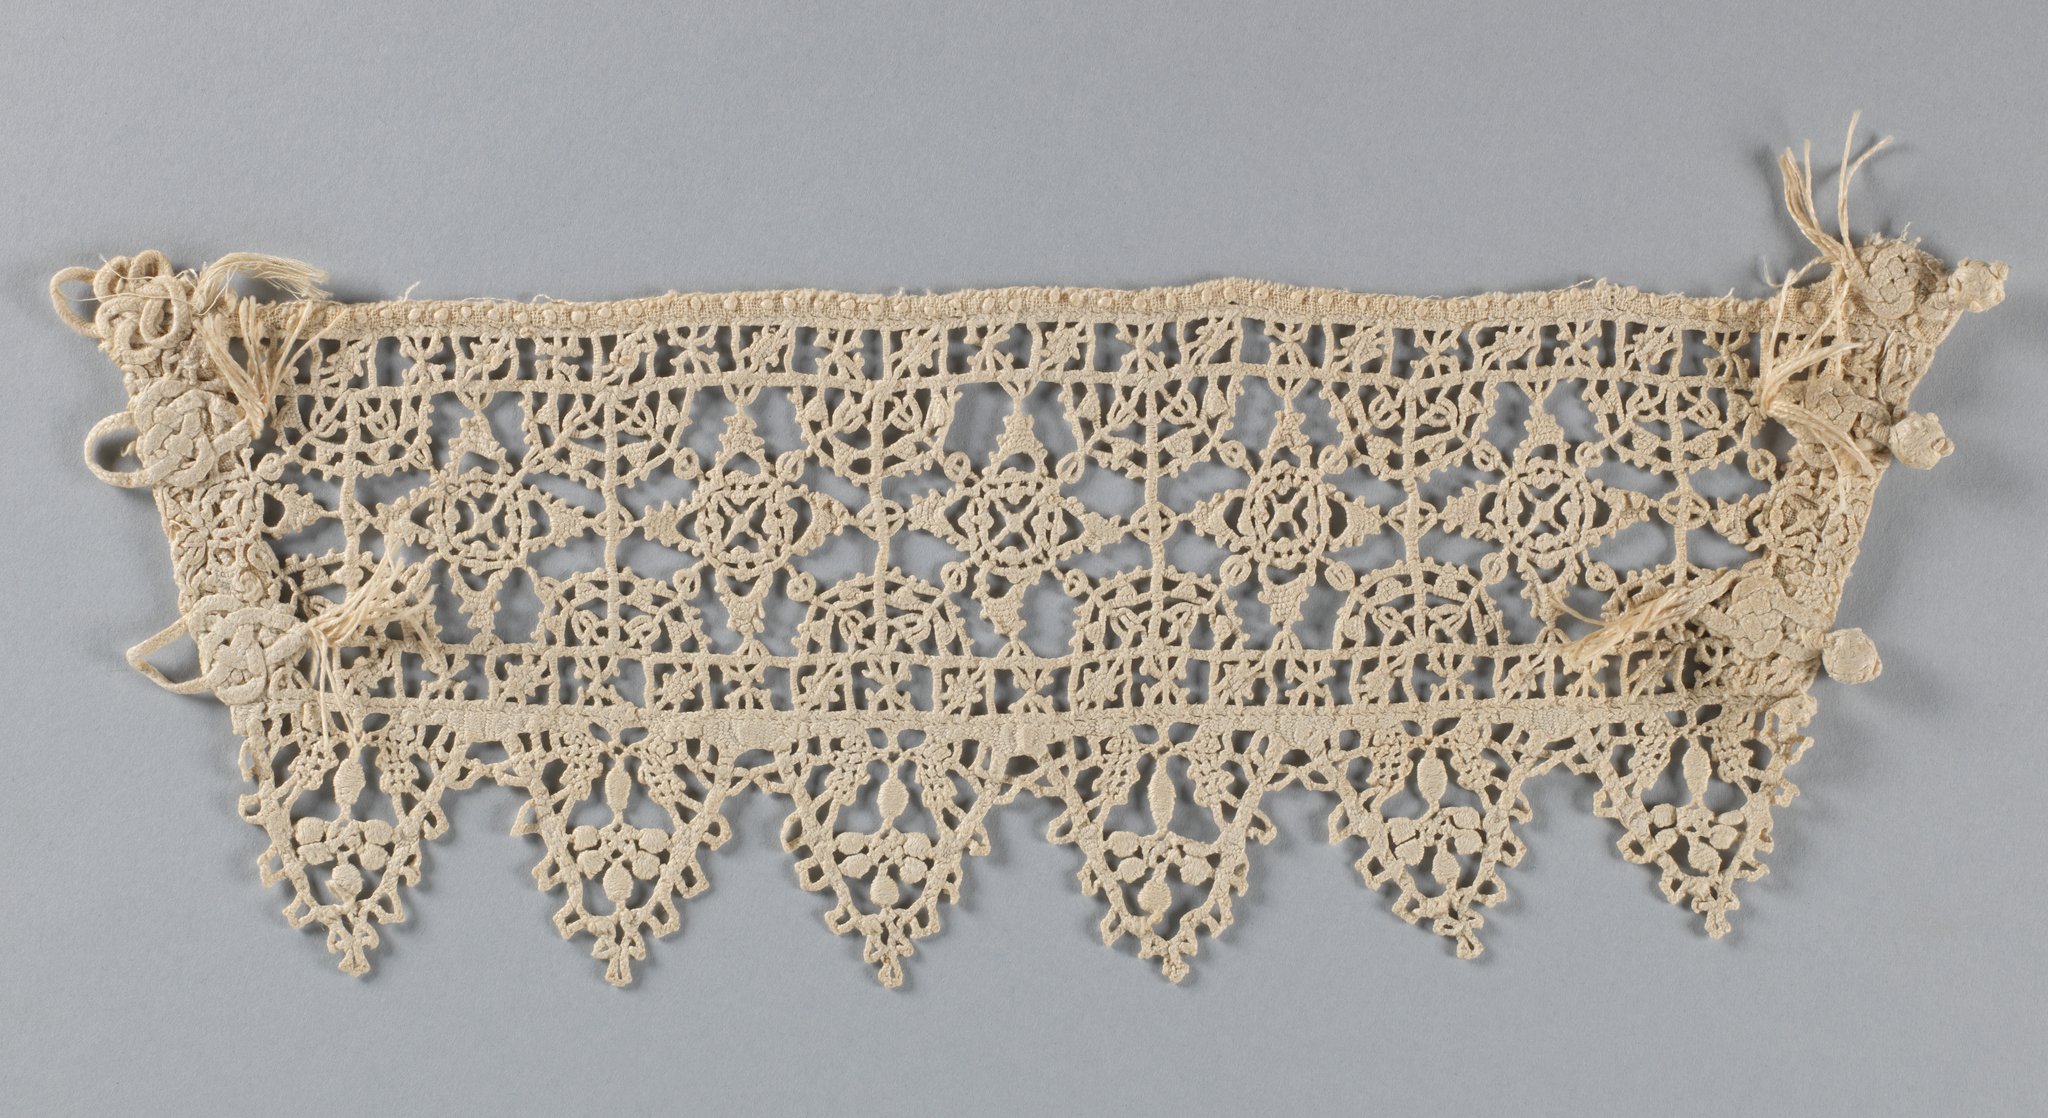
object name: cuff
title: Cuff (one of a pair)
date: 1501-1600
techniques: lace